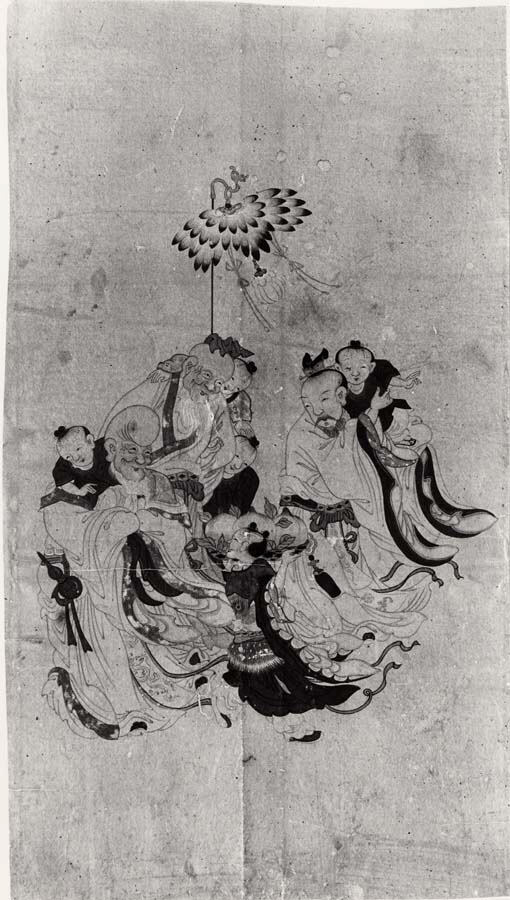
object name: album leaf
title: Wise Men and Children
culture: korean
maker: unidentified artist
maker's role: artist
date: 1801-1900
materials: ink, paper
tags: children,men